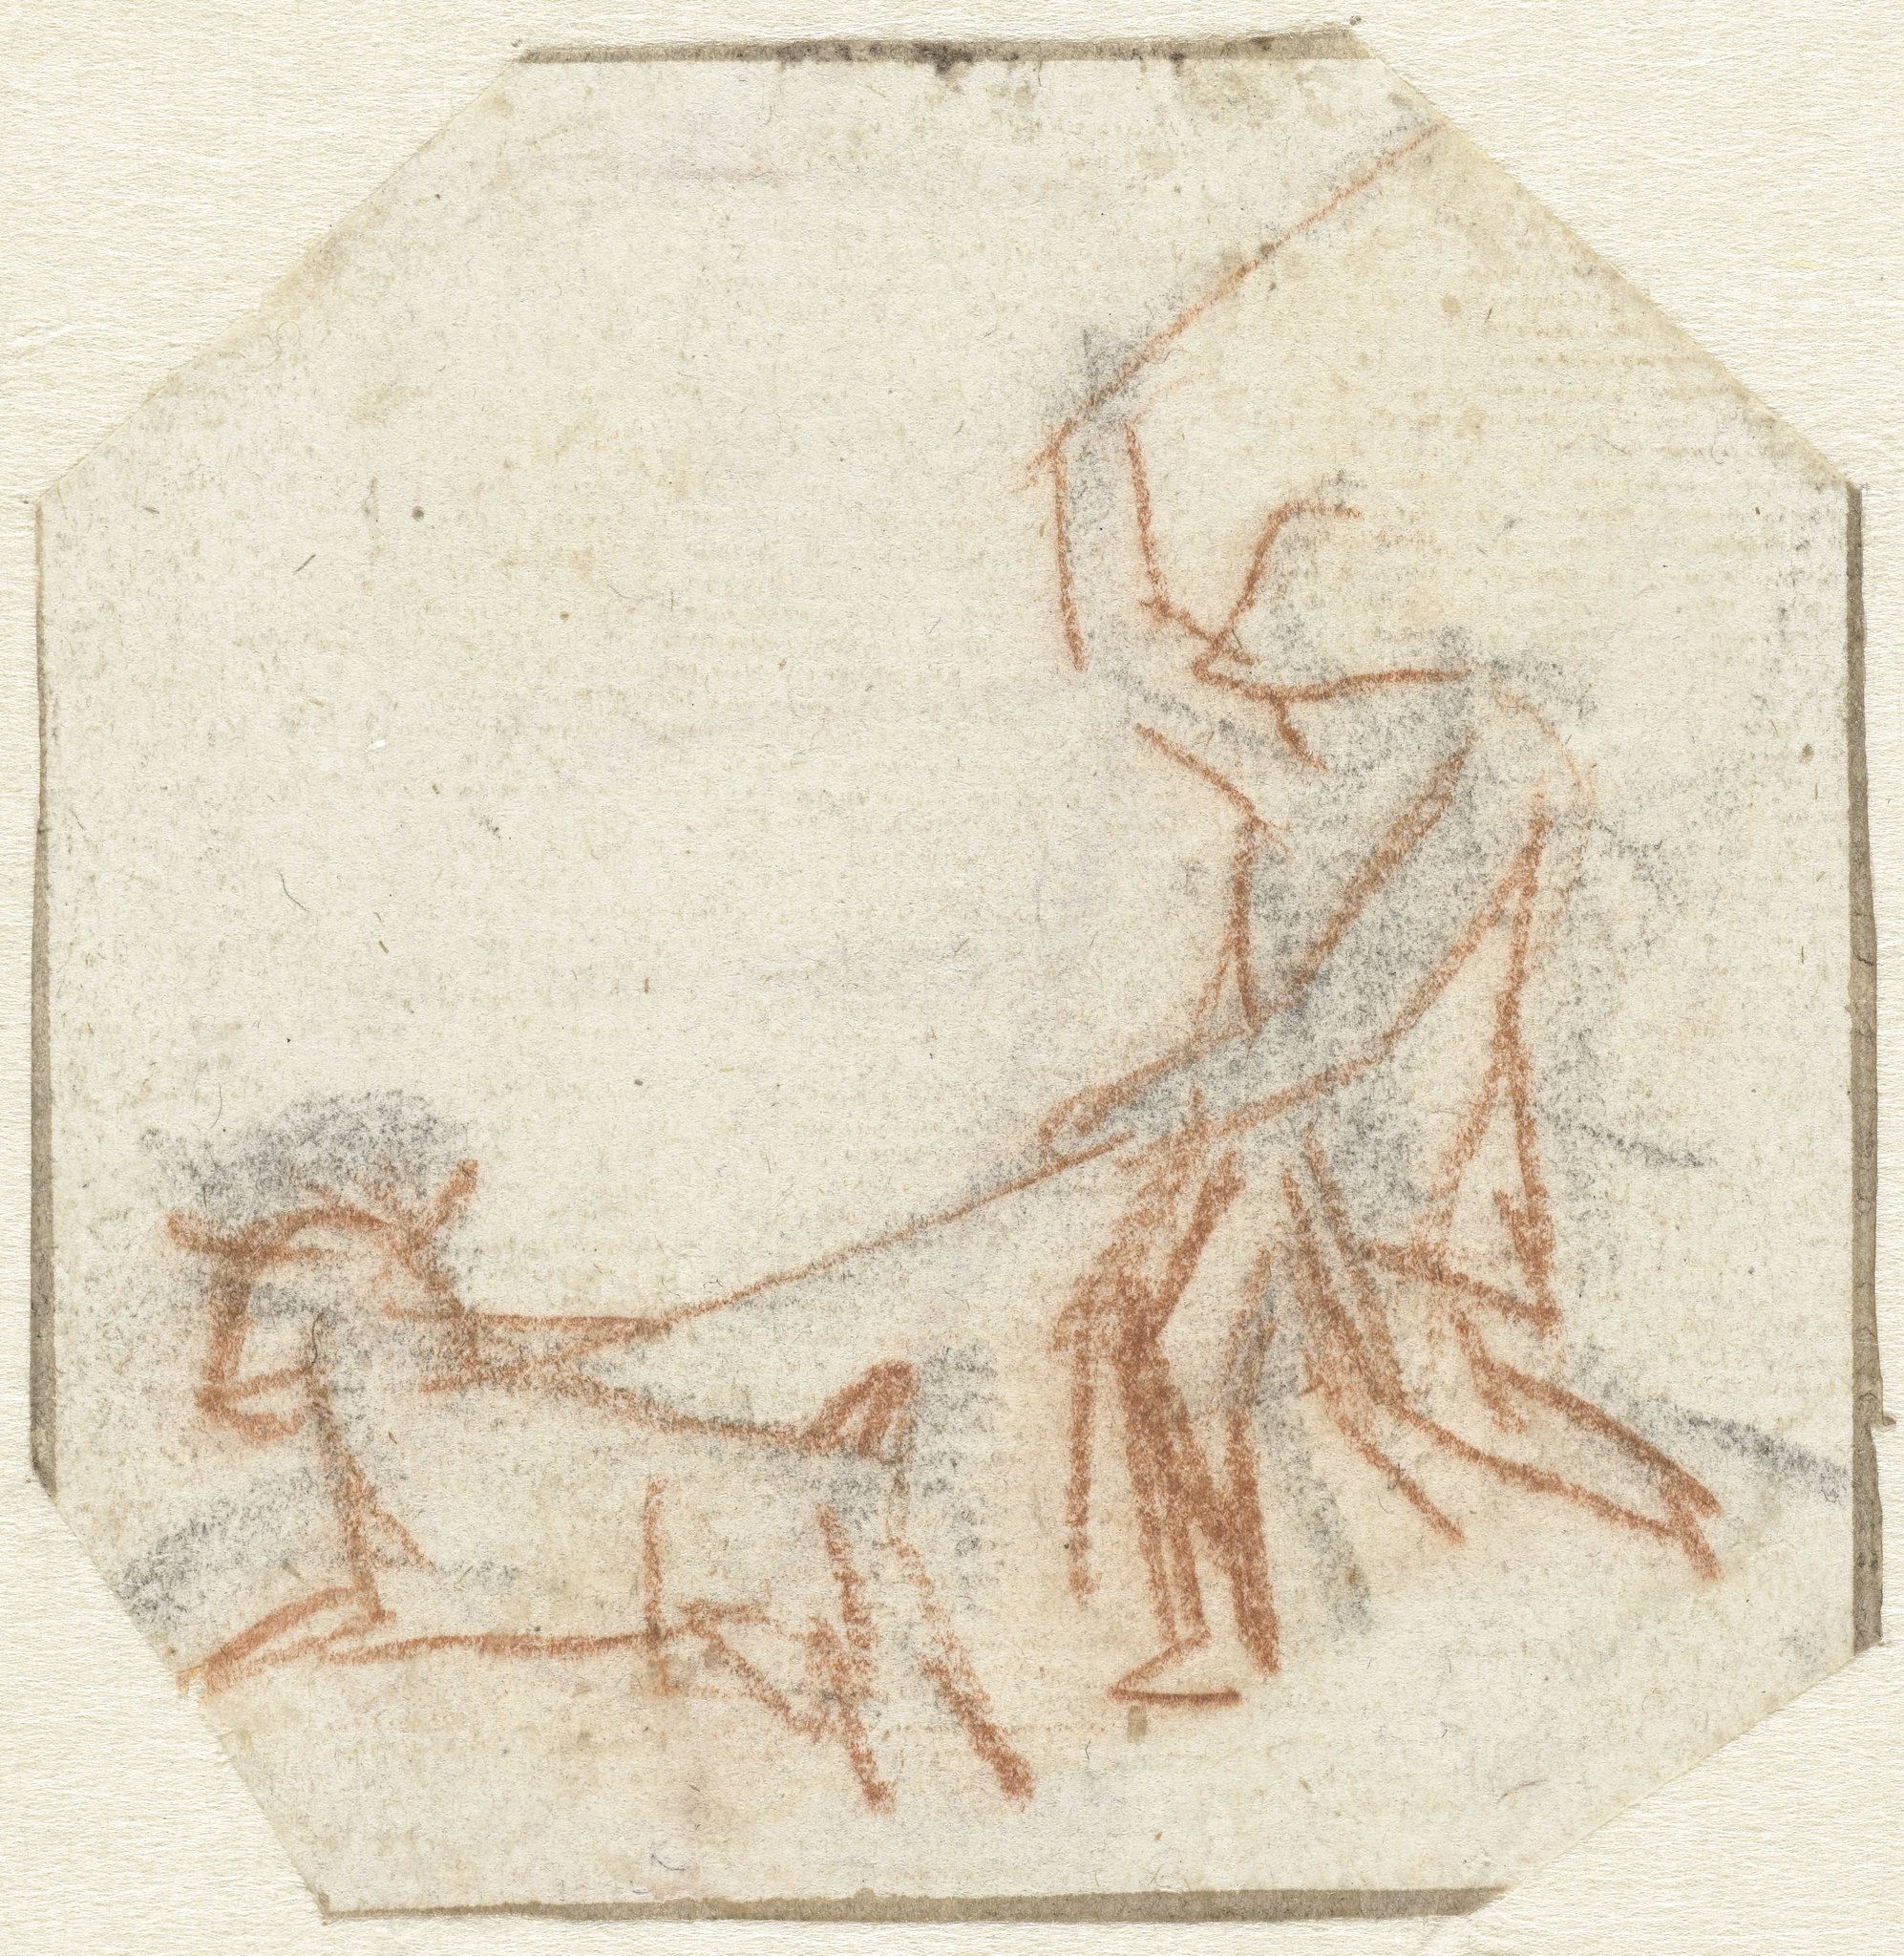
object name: drawing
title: Man drijft een geit aan een touw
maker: simon andreas krausz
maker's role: draughtsman, print maker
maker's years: 1760-1825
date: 1770-1825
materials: chalk, paper